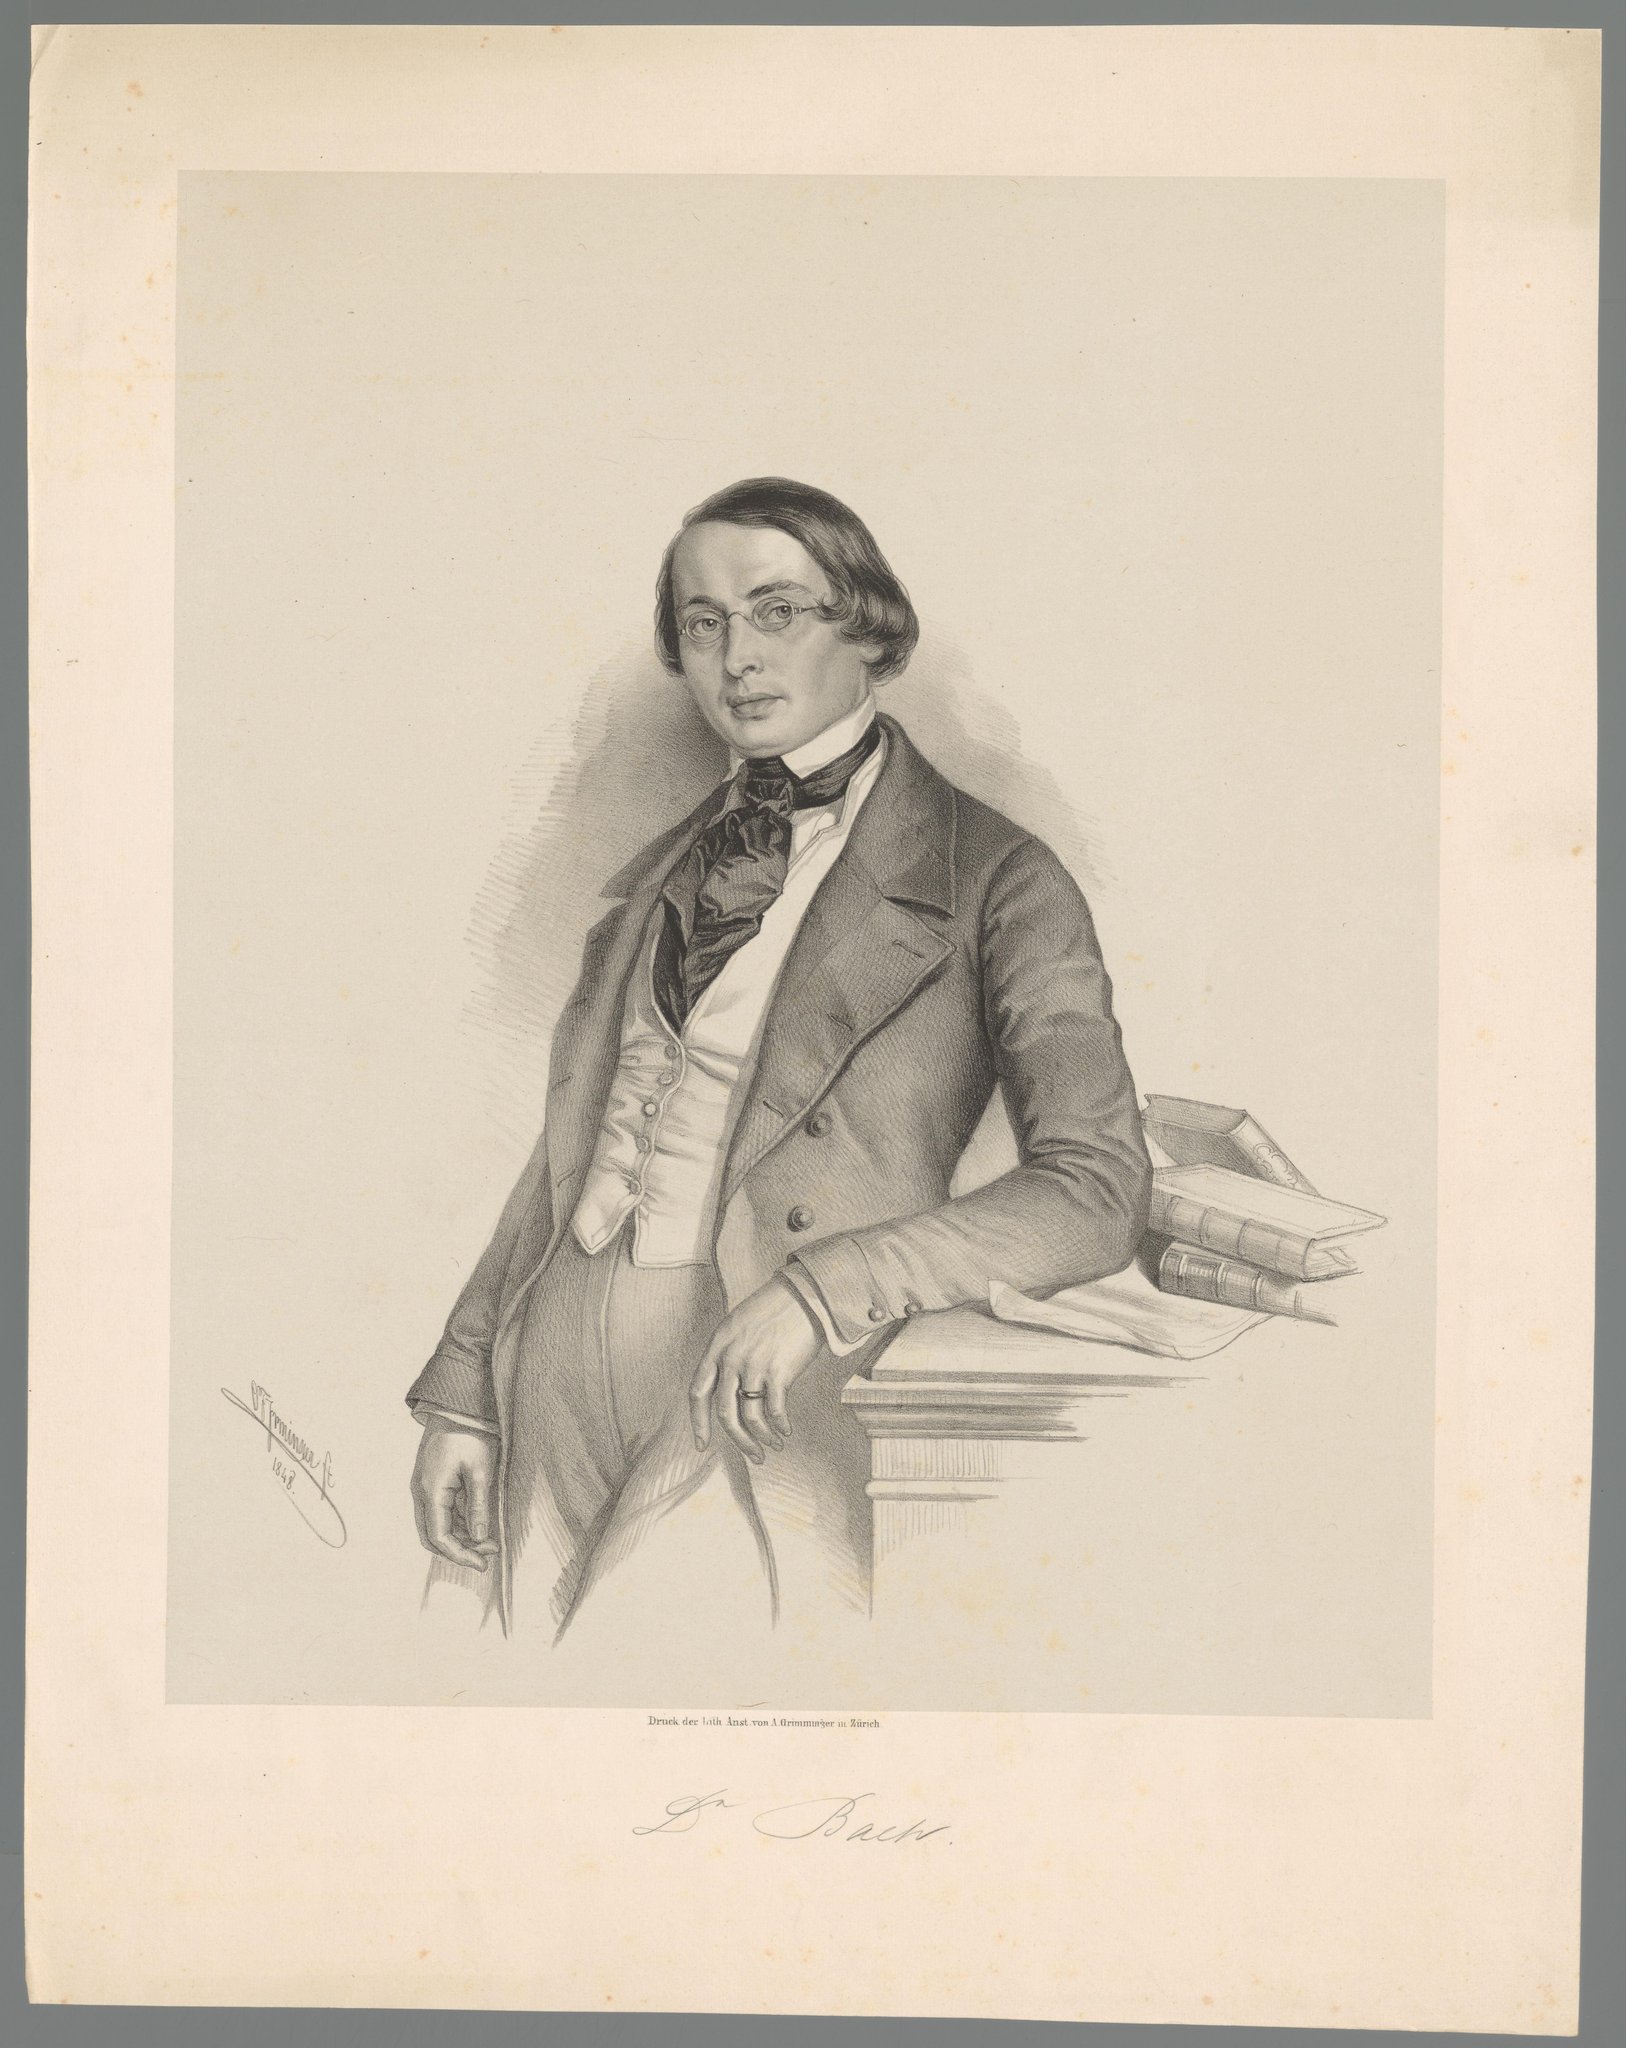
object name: print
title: Portret van een onbekende man, mogelijk Ernst Bach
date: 1848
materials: paper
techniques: lithograph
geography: zurich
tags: eyeglasses, spectacles, adult man, historical persons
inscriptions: collector's mark: Lugt 2228, inscription: ‘Dr. Bach.’